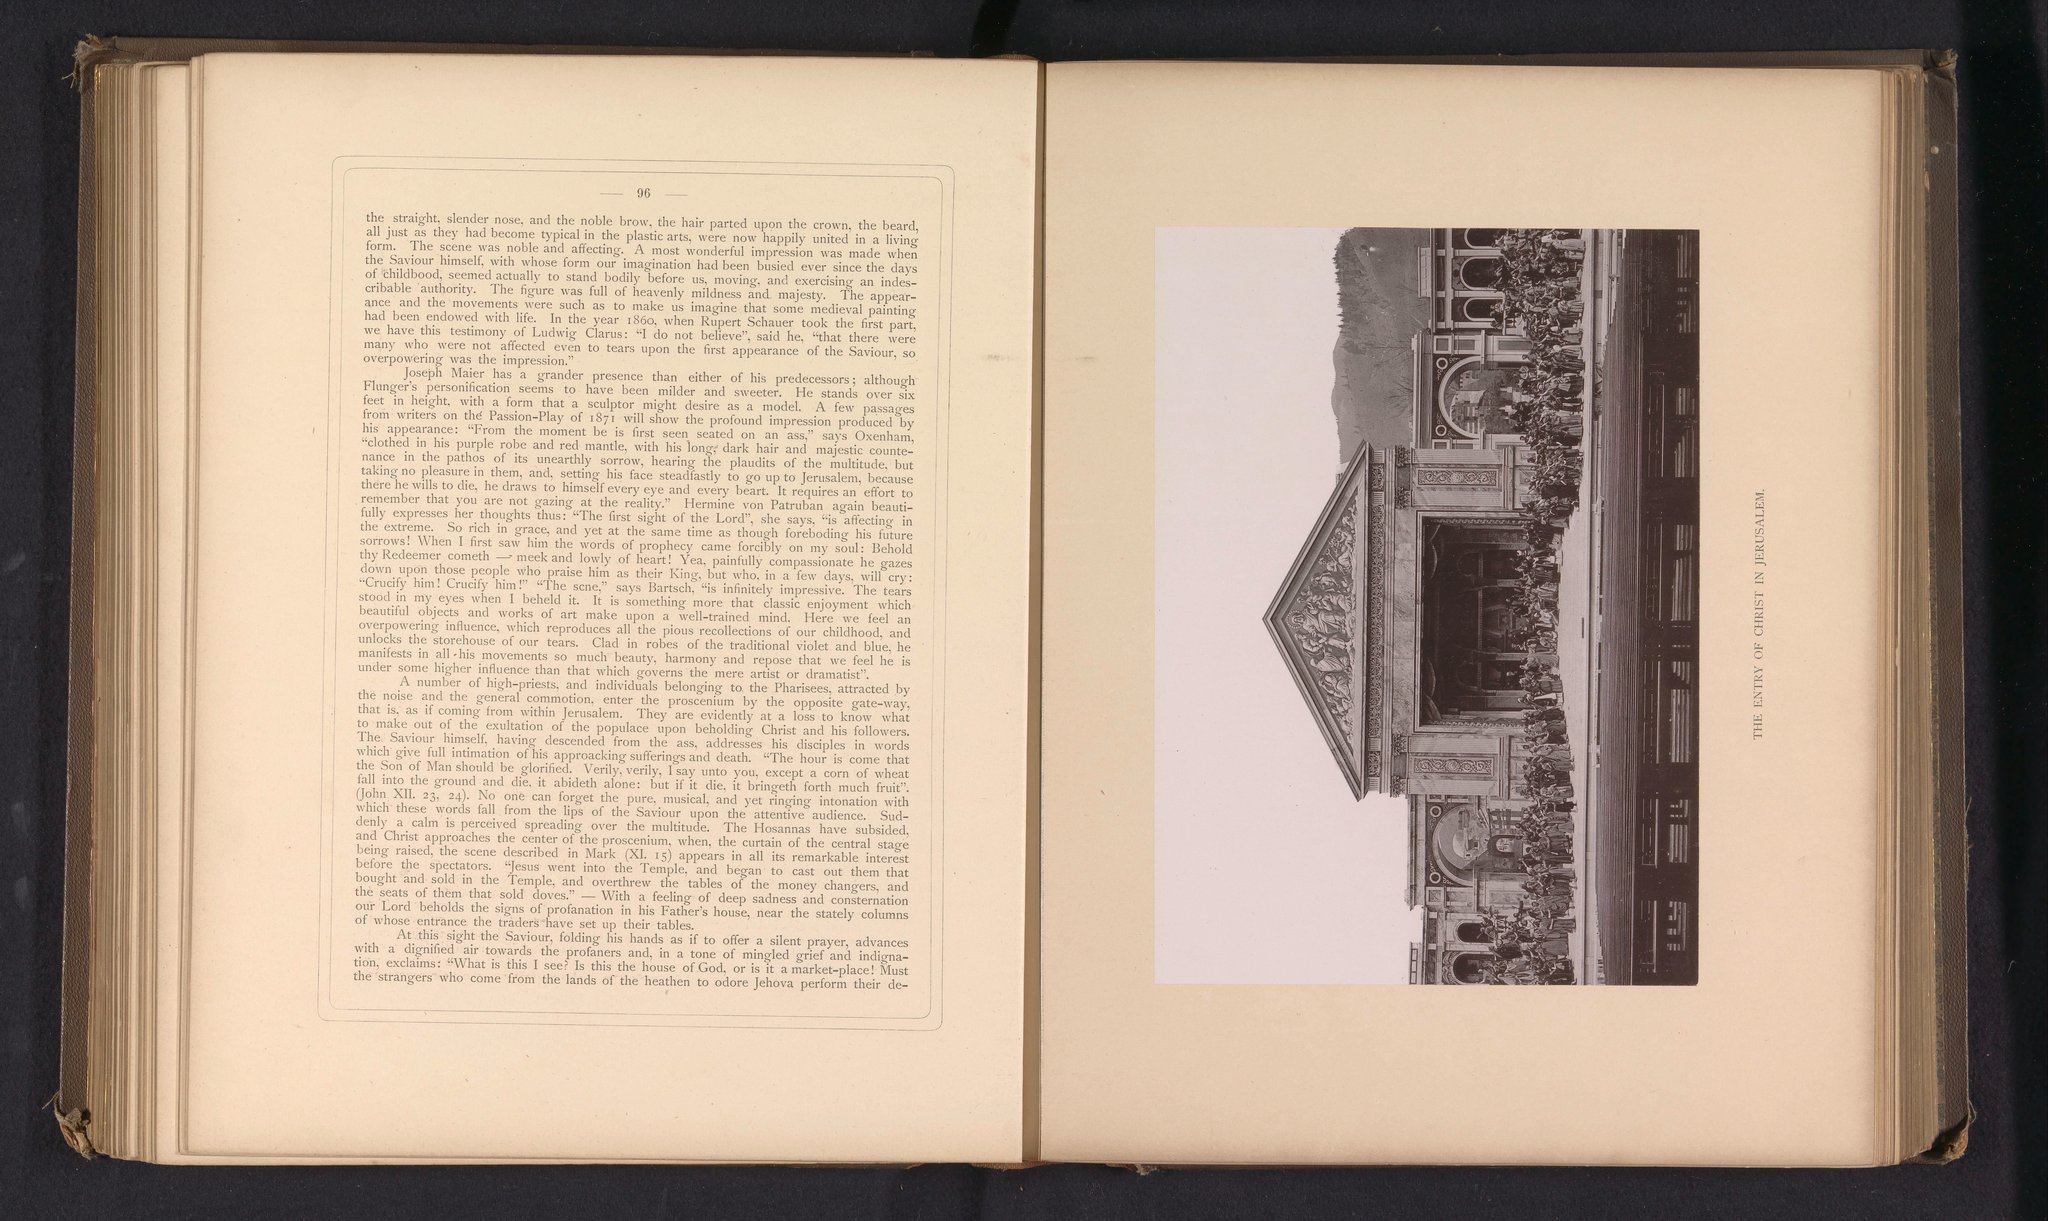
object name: photomechanical print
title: The entry of Christ in Jerusalem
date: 1885-1890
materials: paper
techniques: photograph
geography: oberammergau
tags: group of actors, troupe; actors on the stage, entry into jerusalem: people spreading their clothes before christ on the ass, and waving palm branches (matthew 21:1-11, 21:14-16; mark 11:1-11; luke 19:28-40; john 12:12-19)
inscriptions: inscription: ‘Gemeinde Oberammergau Passionsspiel 1890’